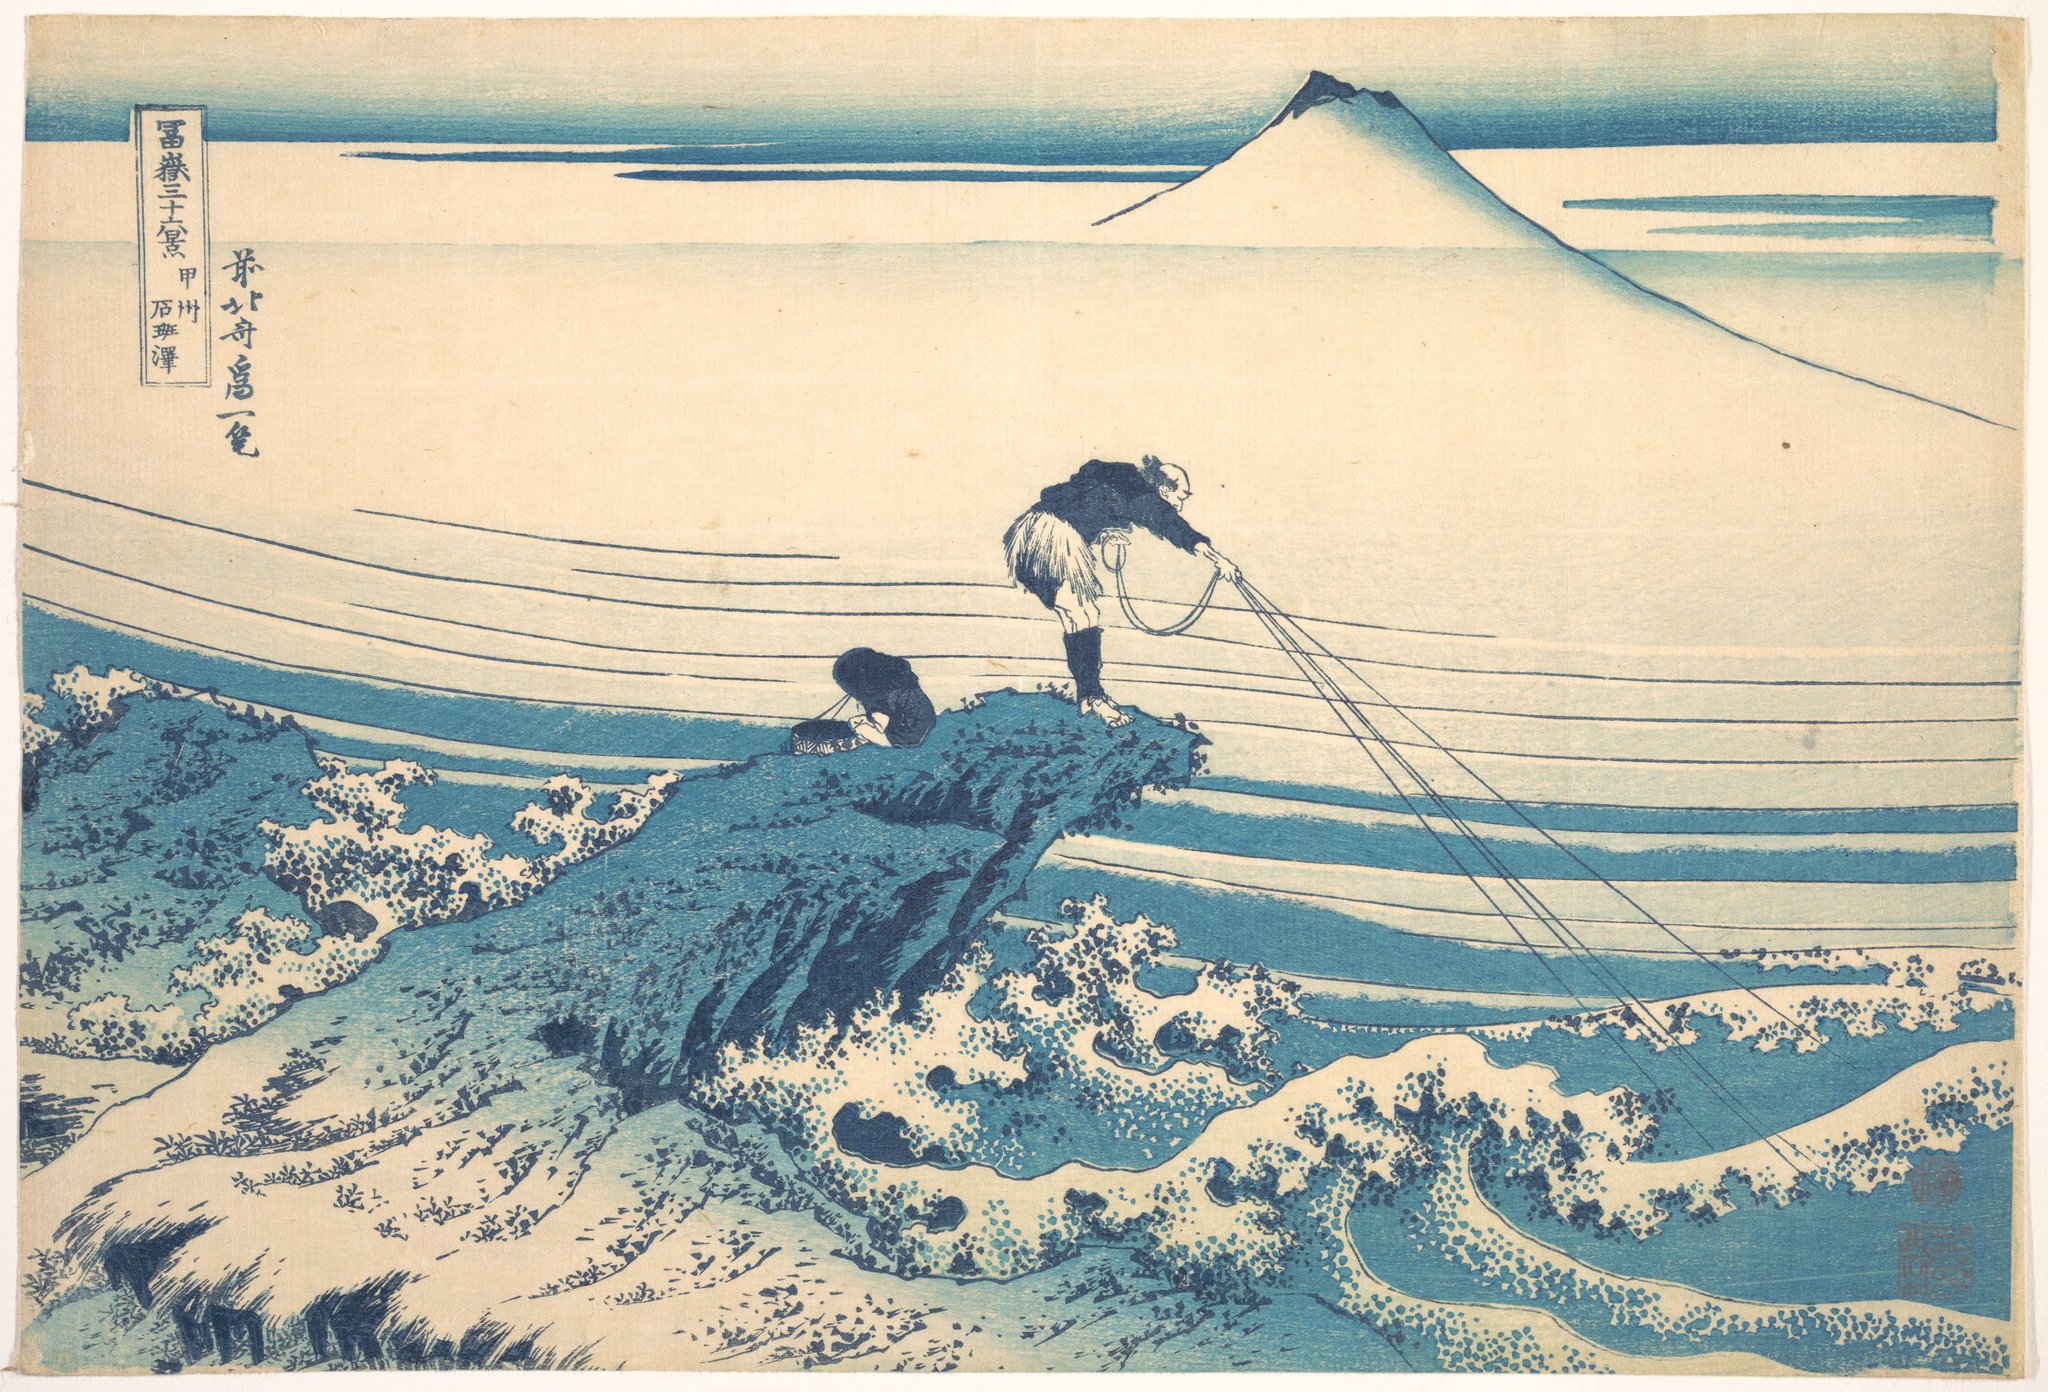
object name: woodblock print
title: Kajikazawa in Kai Province (Kōshū Kajikazawa), from the series Thirty-six Views of Mount Fuji (Fugaku sanjūrokkei)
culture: japanese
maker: katsushika hokusai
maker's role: artist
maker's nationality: japanese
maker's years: 1760-1849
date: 1830-1832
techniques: woodblock print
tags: men,mountains,waves